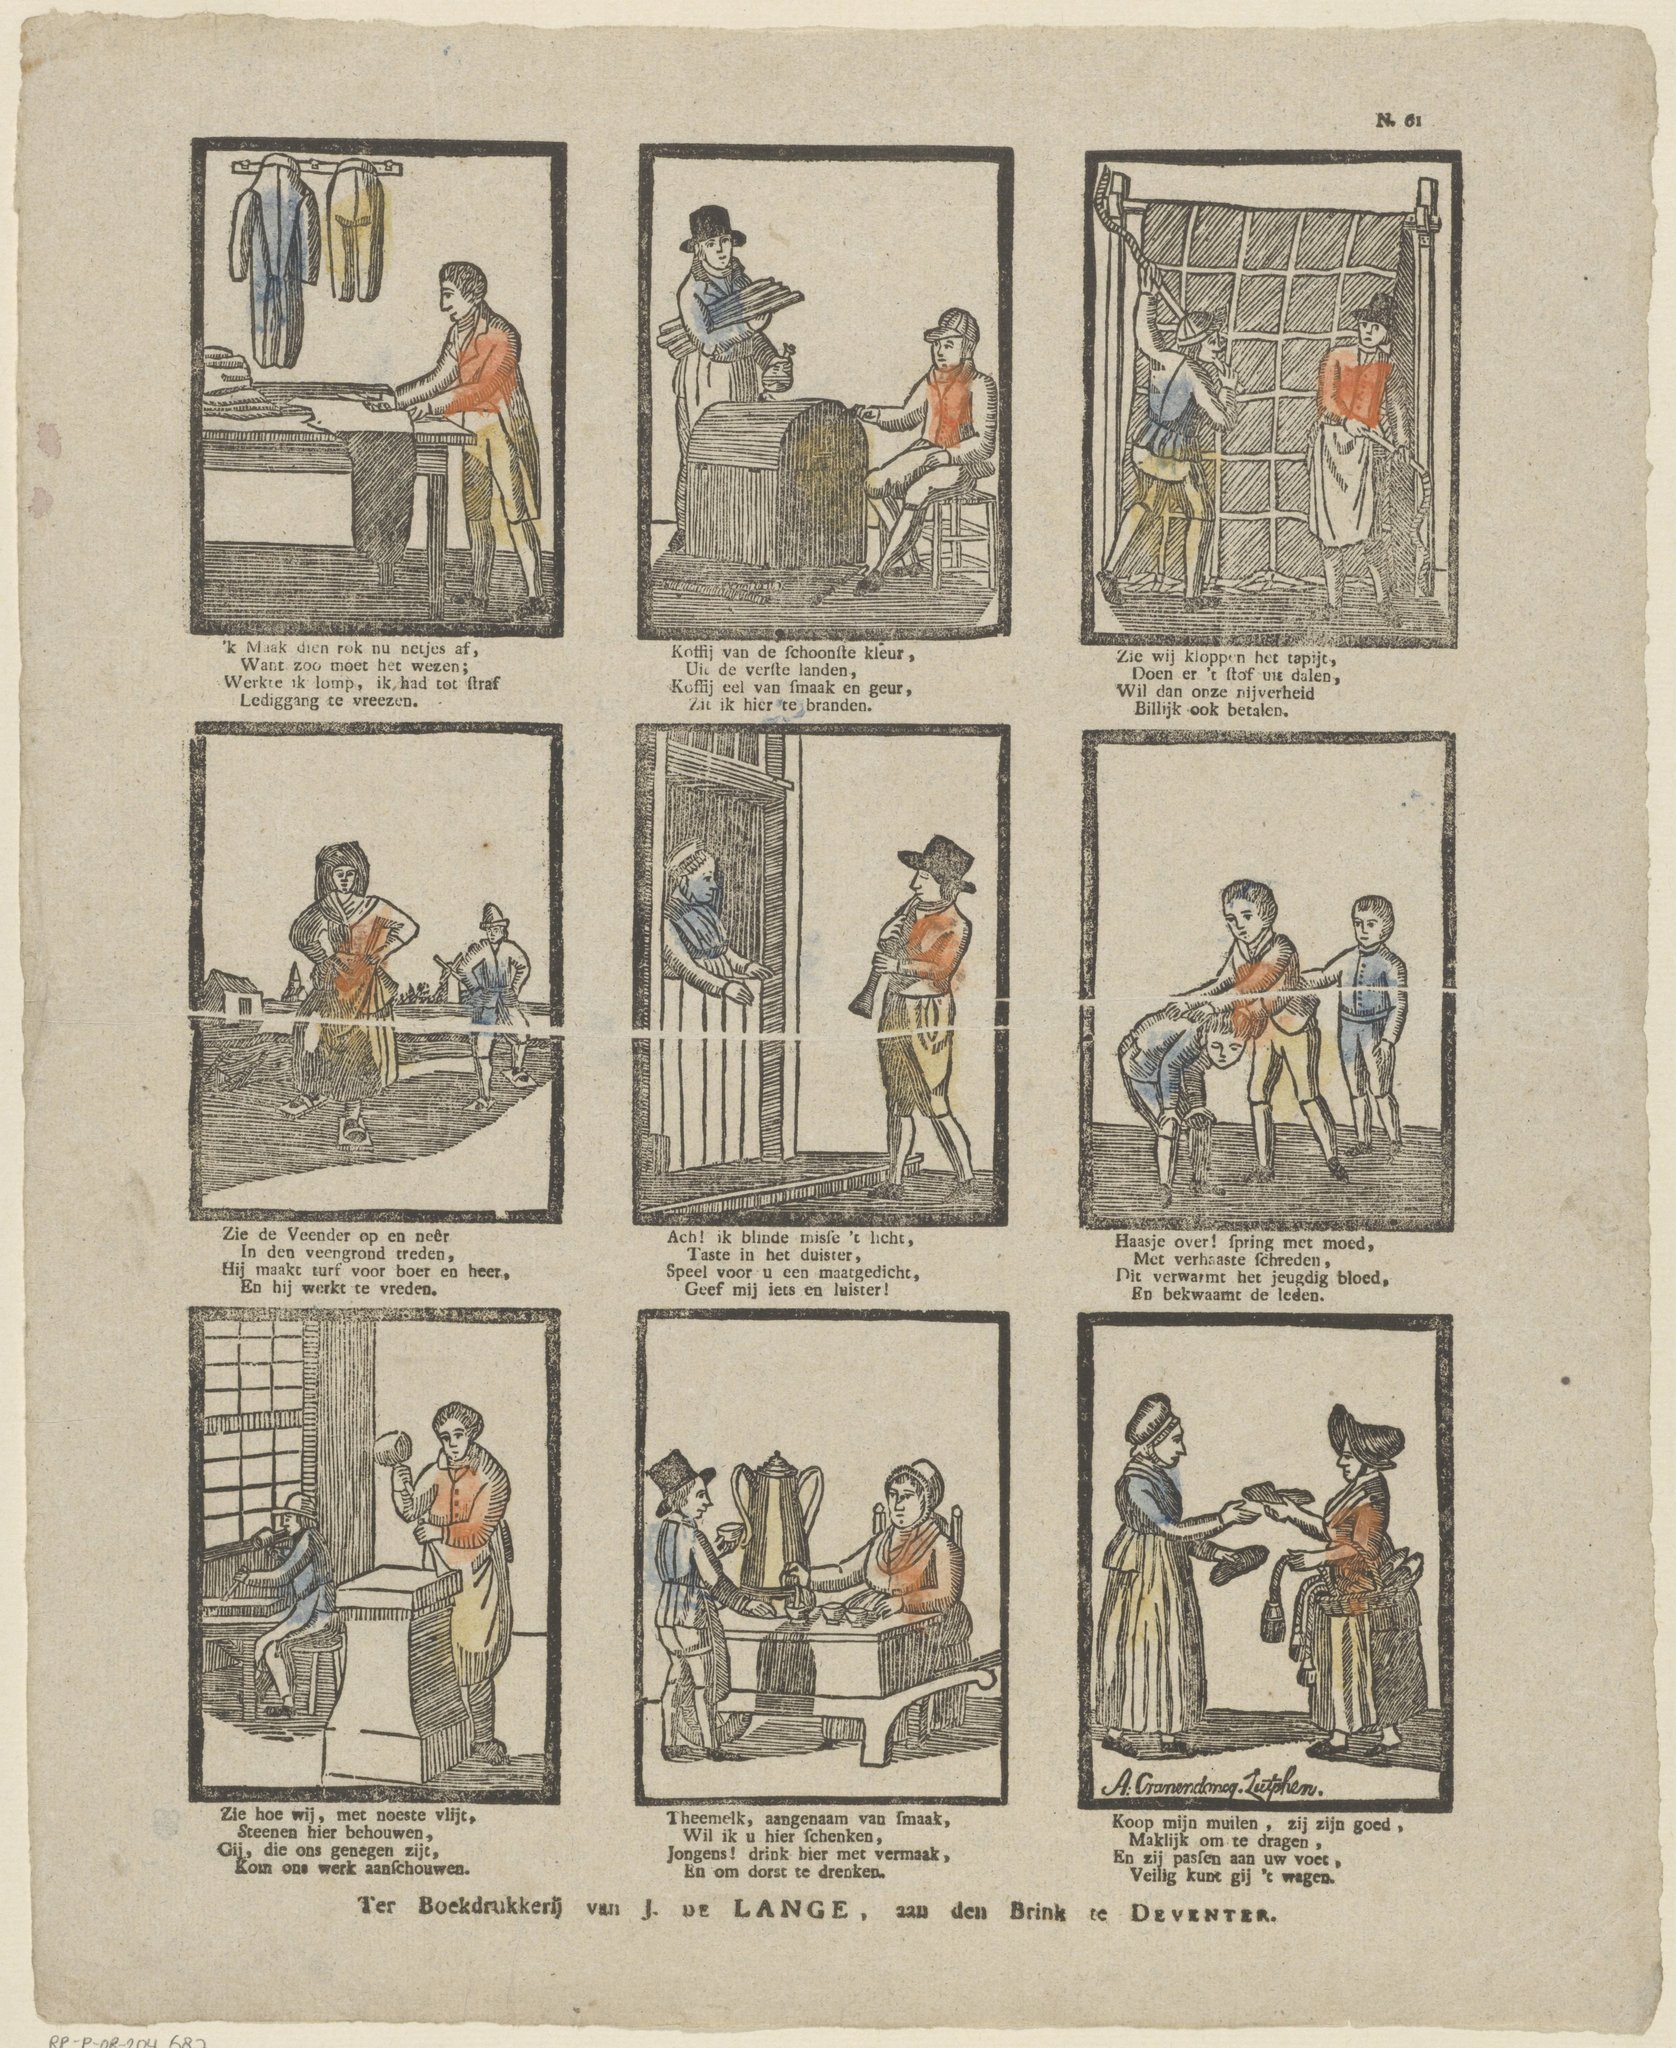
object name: popular print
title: Ambachten en beroepen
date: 1822-1849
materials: paper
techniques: colour, letterpress printing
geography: zutphen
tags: craft-production, skilled handiwork, working class, labourers, street-trader, crafts and industries, merchant, salesman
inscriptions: collector's mark: Lugt 2760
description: Blad met 9 voorstellingen van ambachtslieden en beroepen, zoals kleermaker, mattenklopper en straatverkoper. Onder elke afbeelding een vierregelig vers. Genummerd rechtsboven: N. 61.